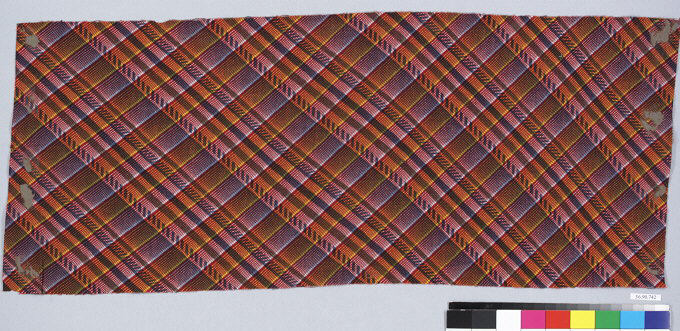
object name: piece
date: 1867-1900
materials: cotton